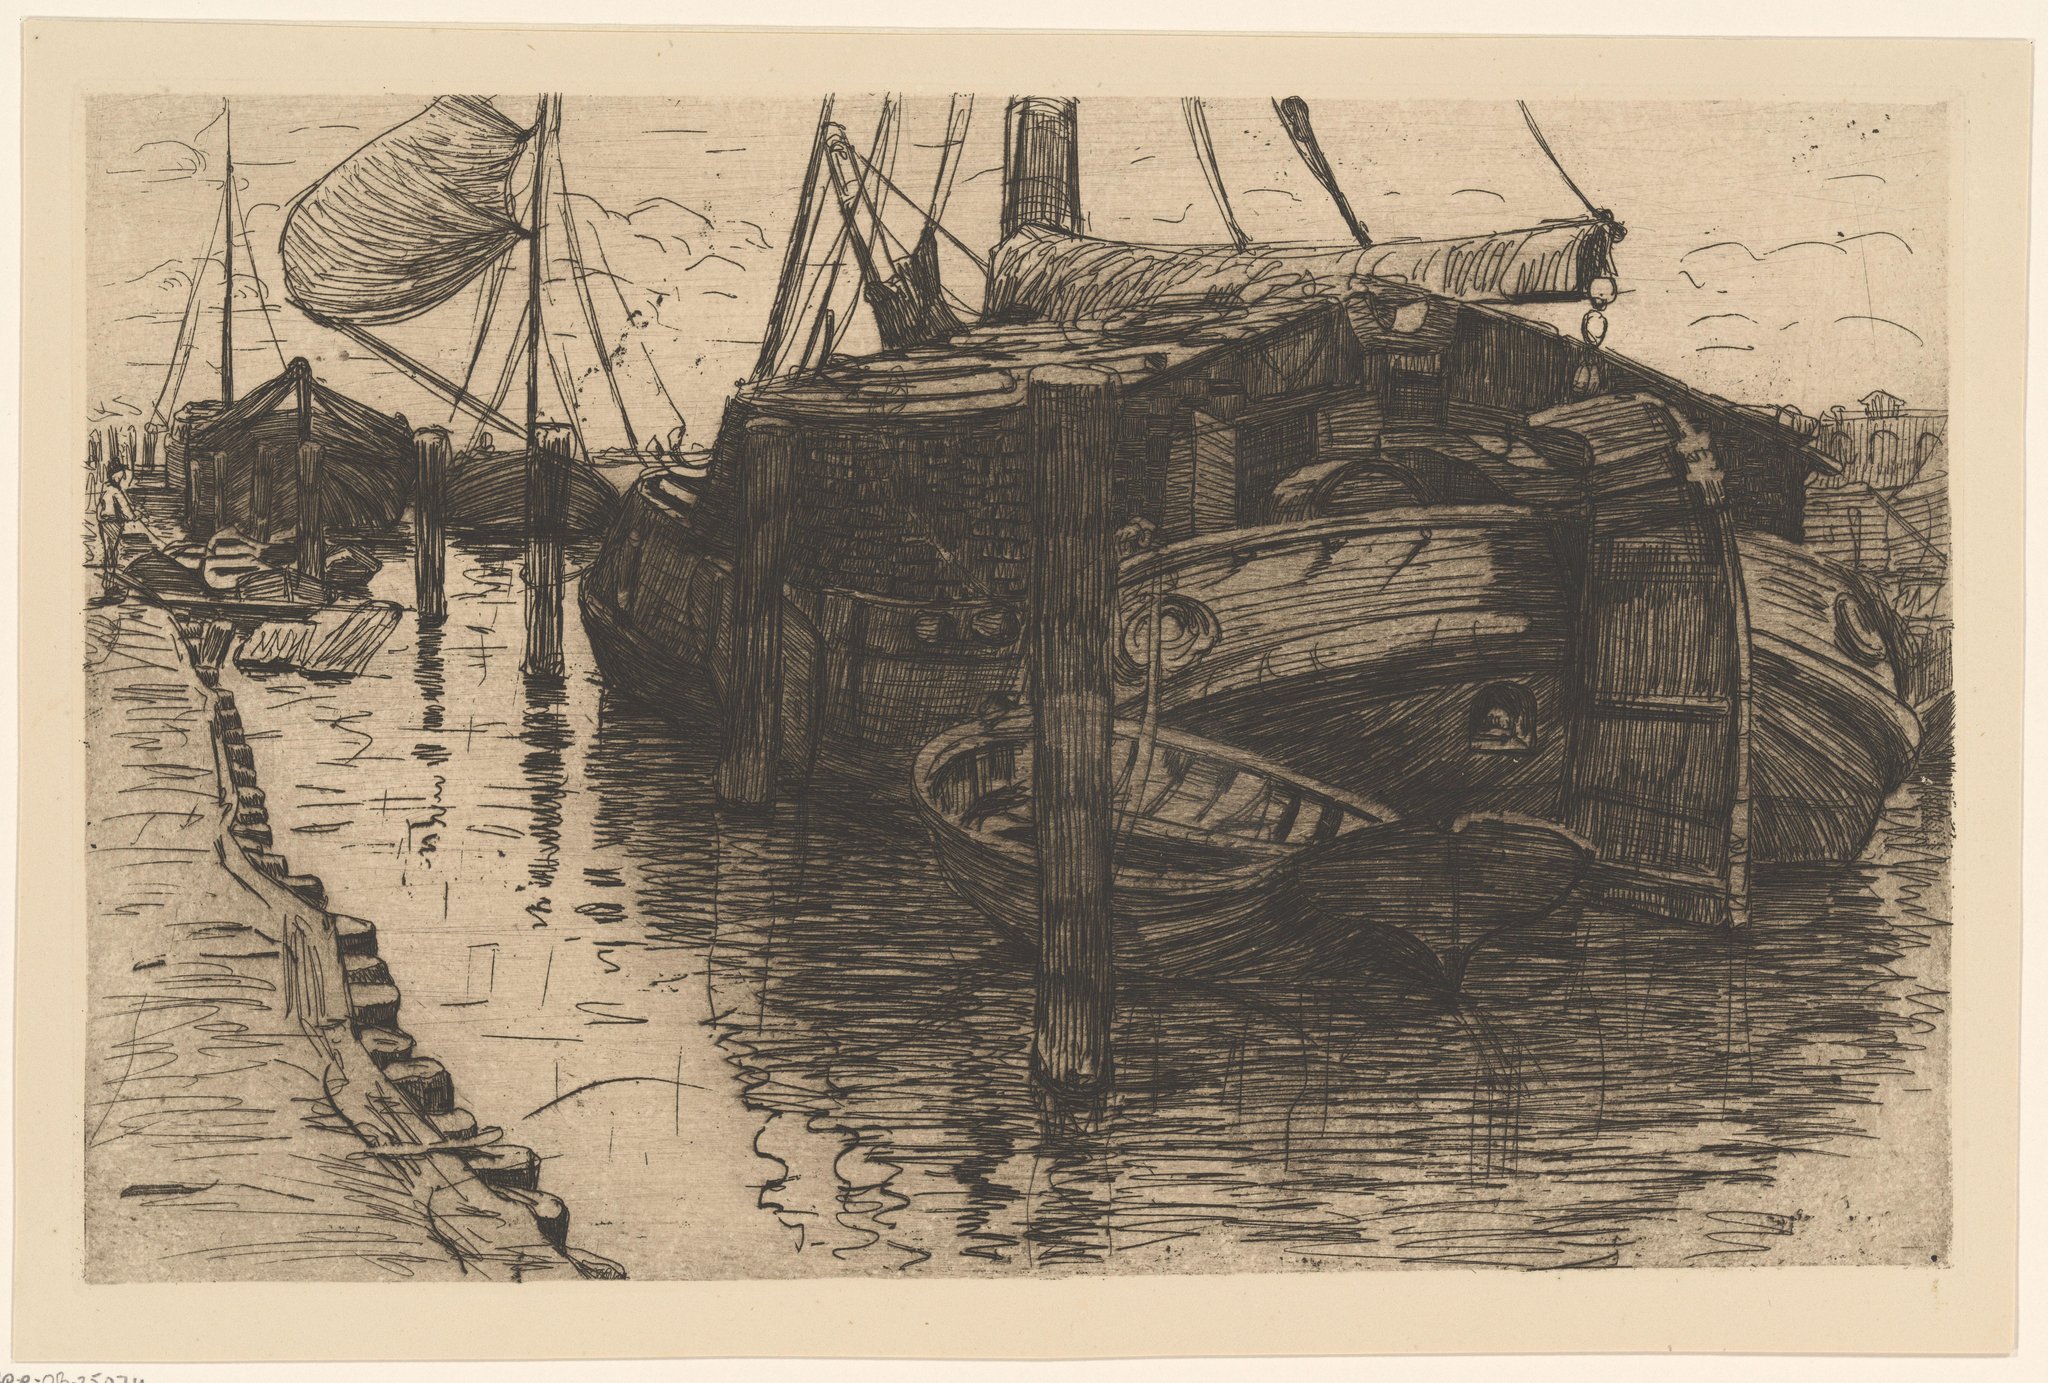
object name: print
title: Aangemeerde boten in een haven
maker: maurits van der valk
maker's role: draughtsman, print maker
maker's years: 1857-1935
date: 1892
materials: paper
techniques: drypoint, etching, intaglio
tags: harbour, sailing-ship, sailing-boat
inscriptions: collector's mark: Lugt 2228